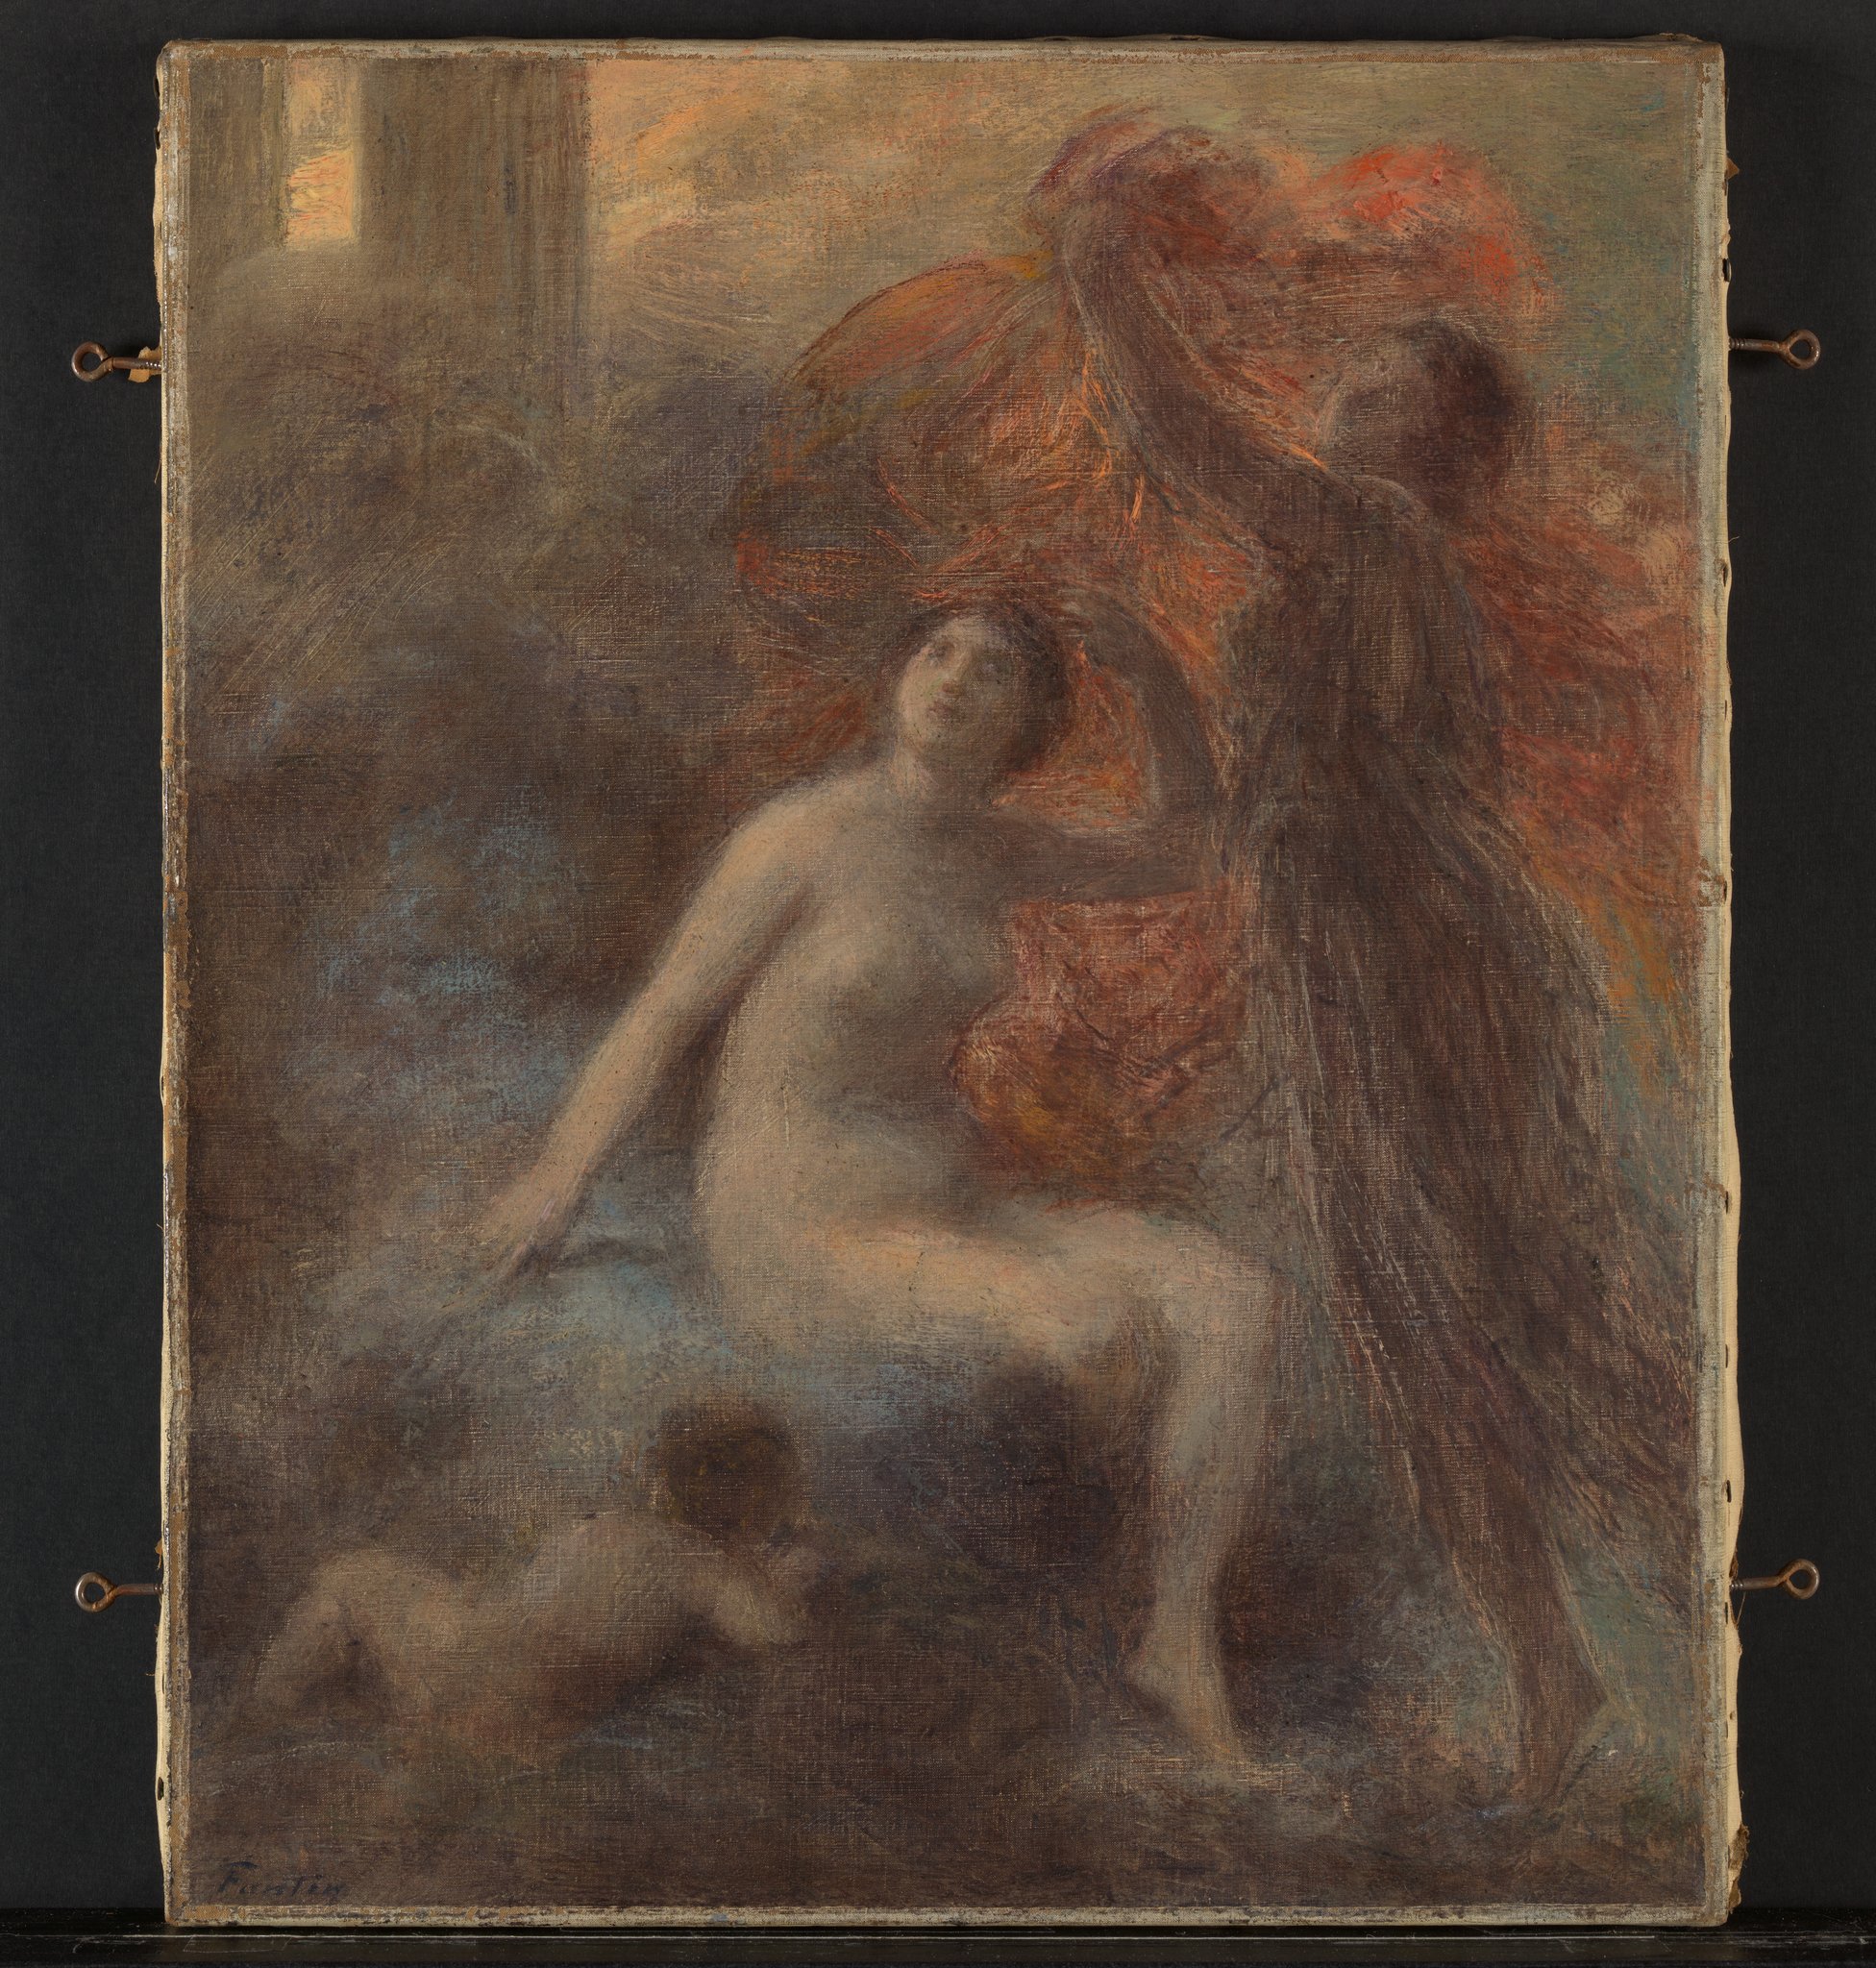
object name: painting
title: The Palace of Aurora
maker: henri fantin-latour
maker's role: artist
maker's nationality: french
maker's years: 1836-1904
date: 1902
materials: canvas, oil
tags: women,female nudes,putti